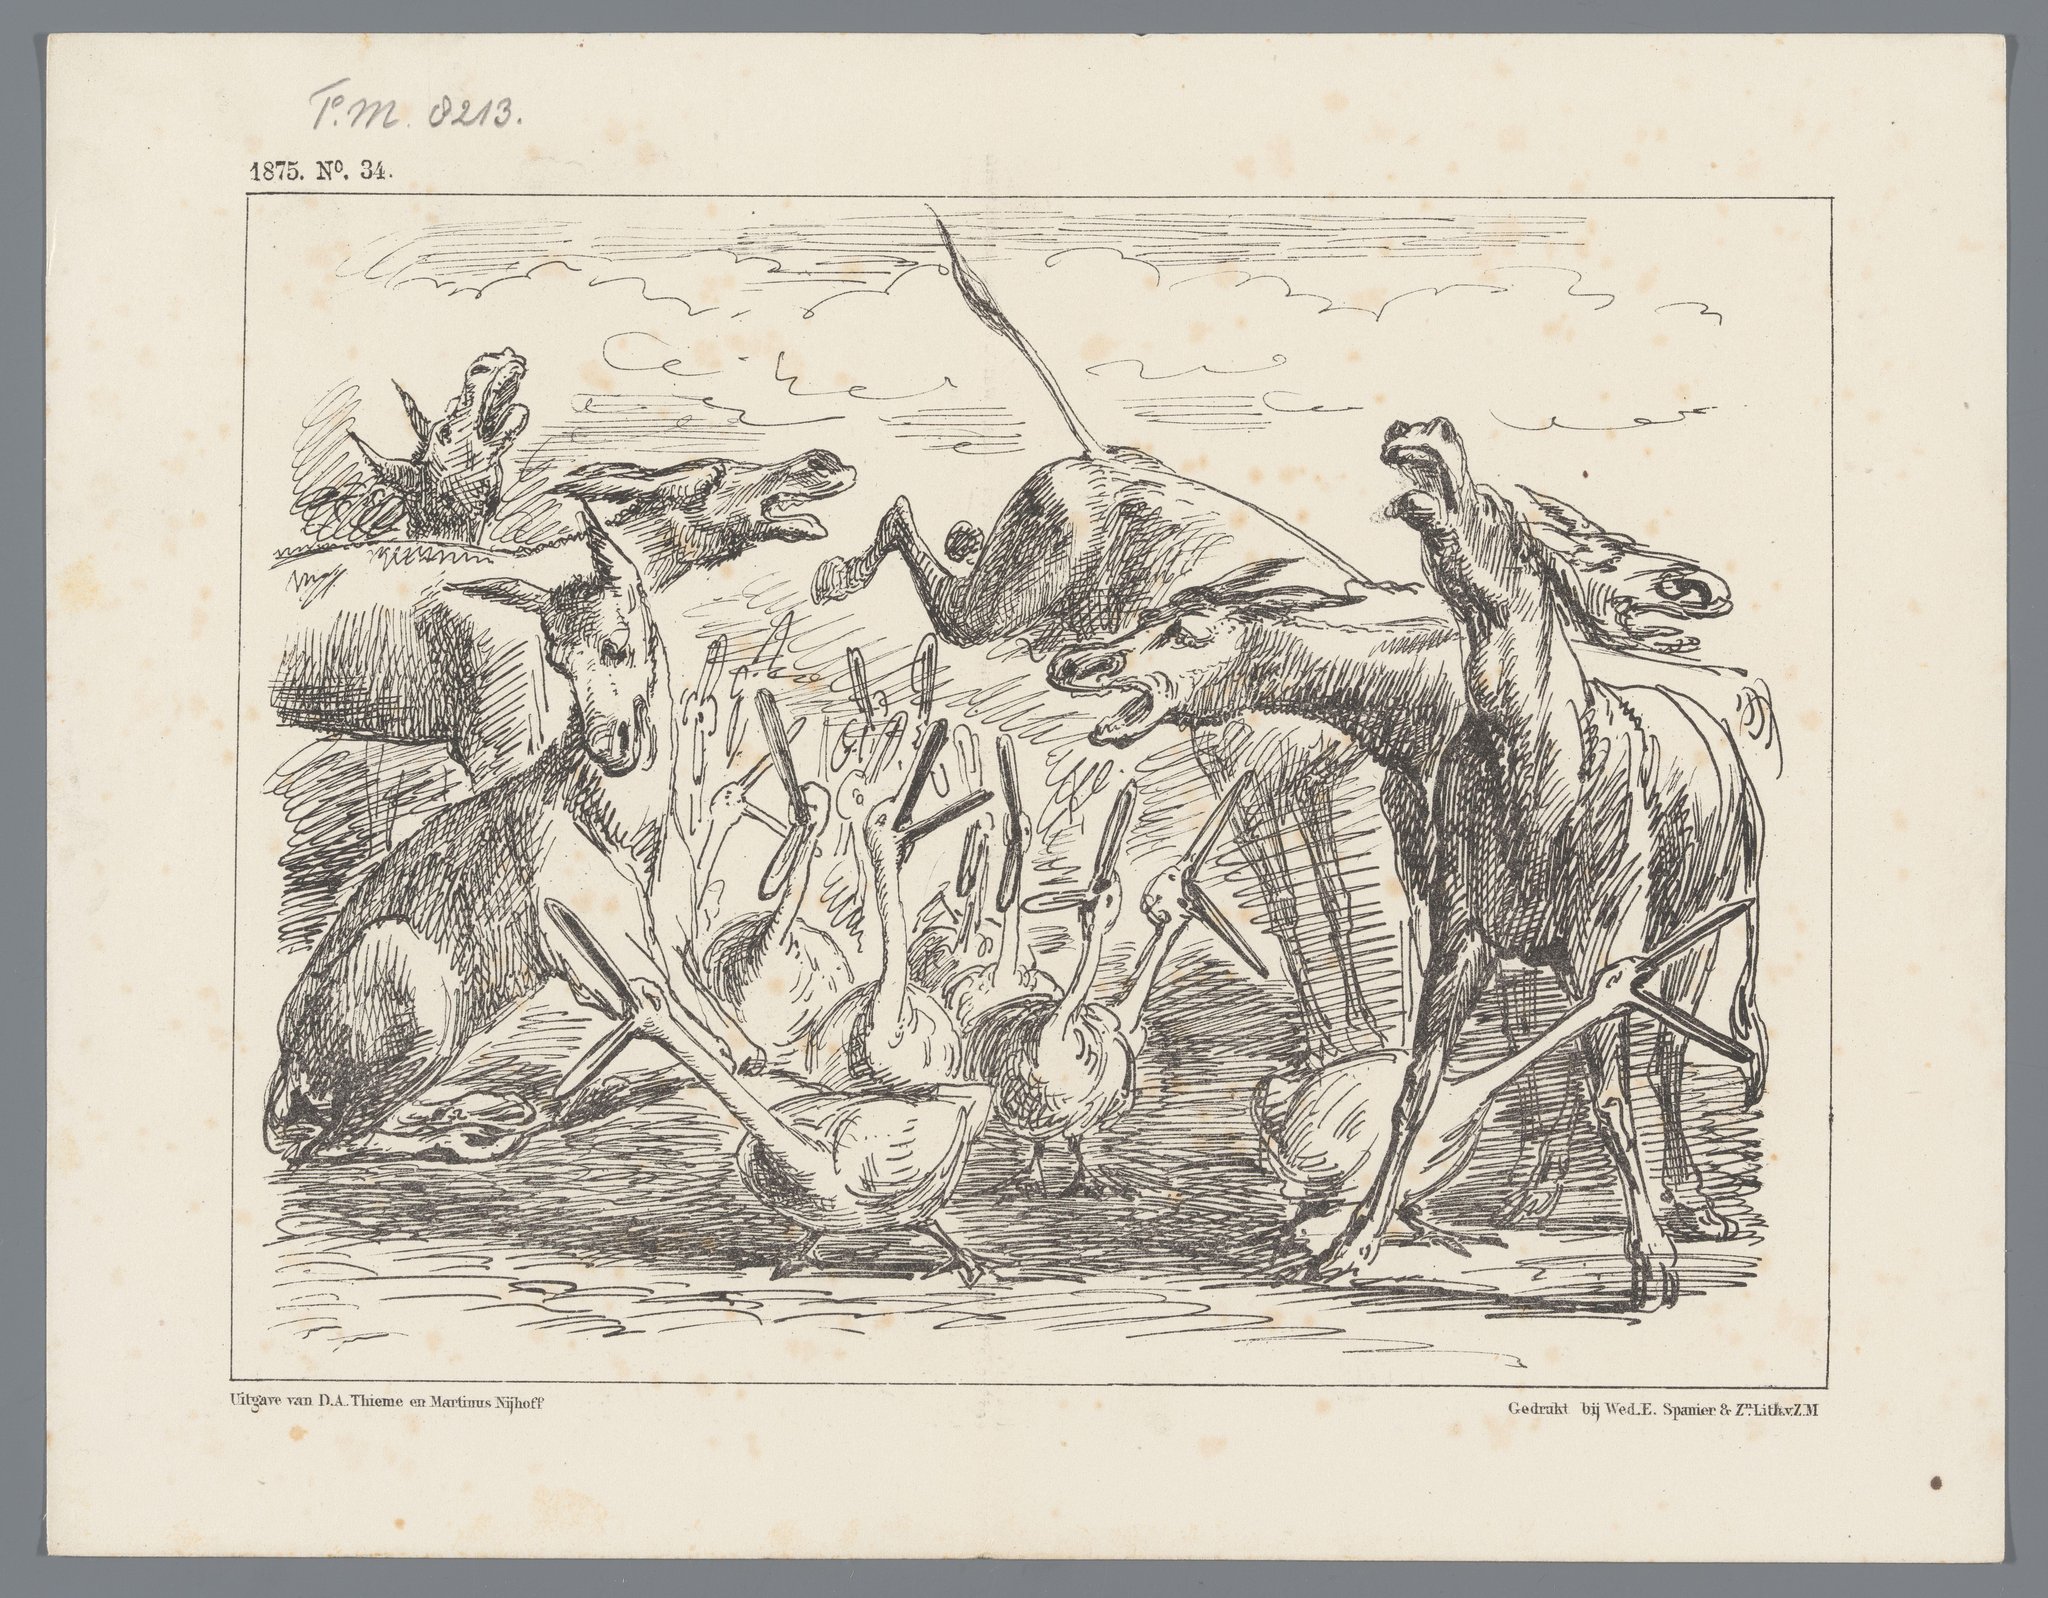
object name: cartoon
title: Spotprent naar aanleiding van de verontwaardigde reacties op de spotprent over het 200-jarige jubileum van de Portugese Synagoge, 1875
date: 1875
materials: paper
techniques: lithograph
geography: the hague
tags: ass, donkey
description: Schreeuwende ganzen en balkende ezels. Spotprent naar aanleiding van de verontwaardigde reacties op de vorige spotprent (nr. 33) over het 200-jarige jubileum van de Portugese Synagoge te Amsterdam, 1675-1875. Plaat verschenen bij het weekblad De Nederlandsche Spectator, nr. 34, 1875.